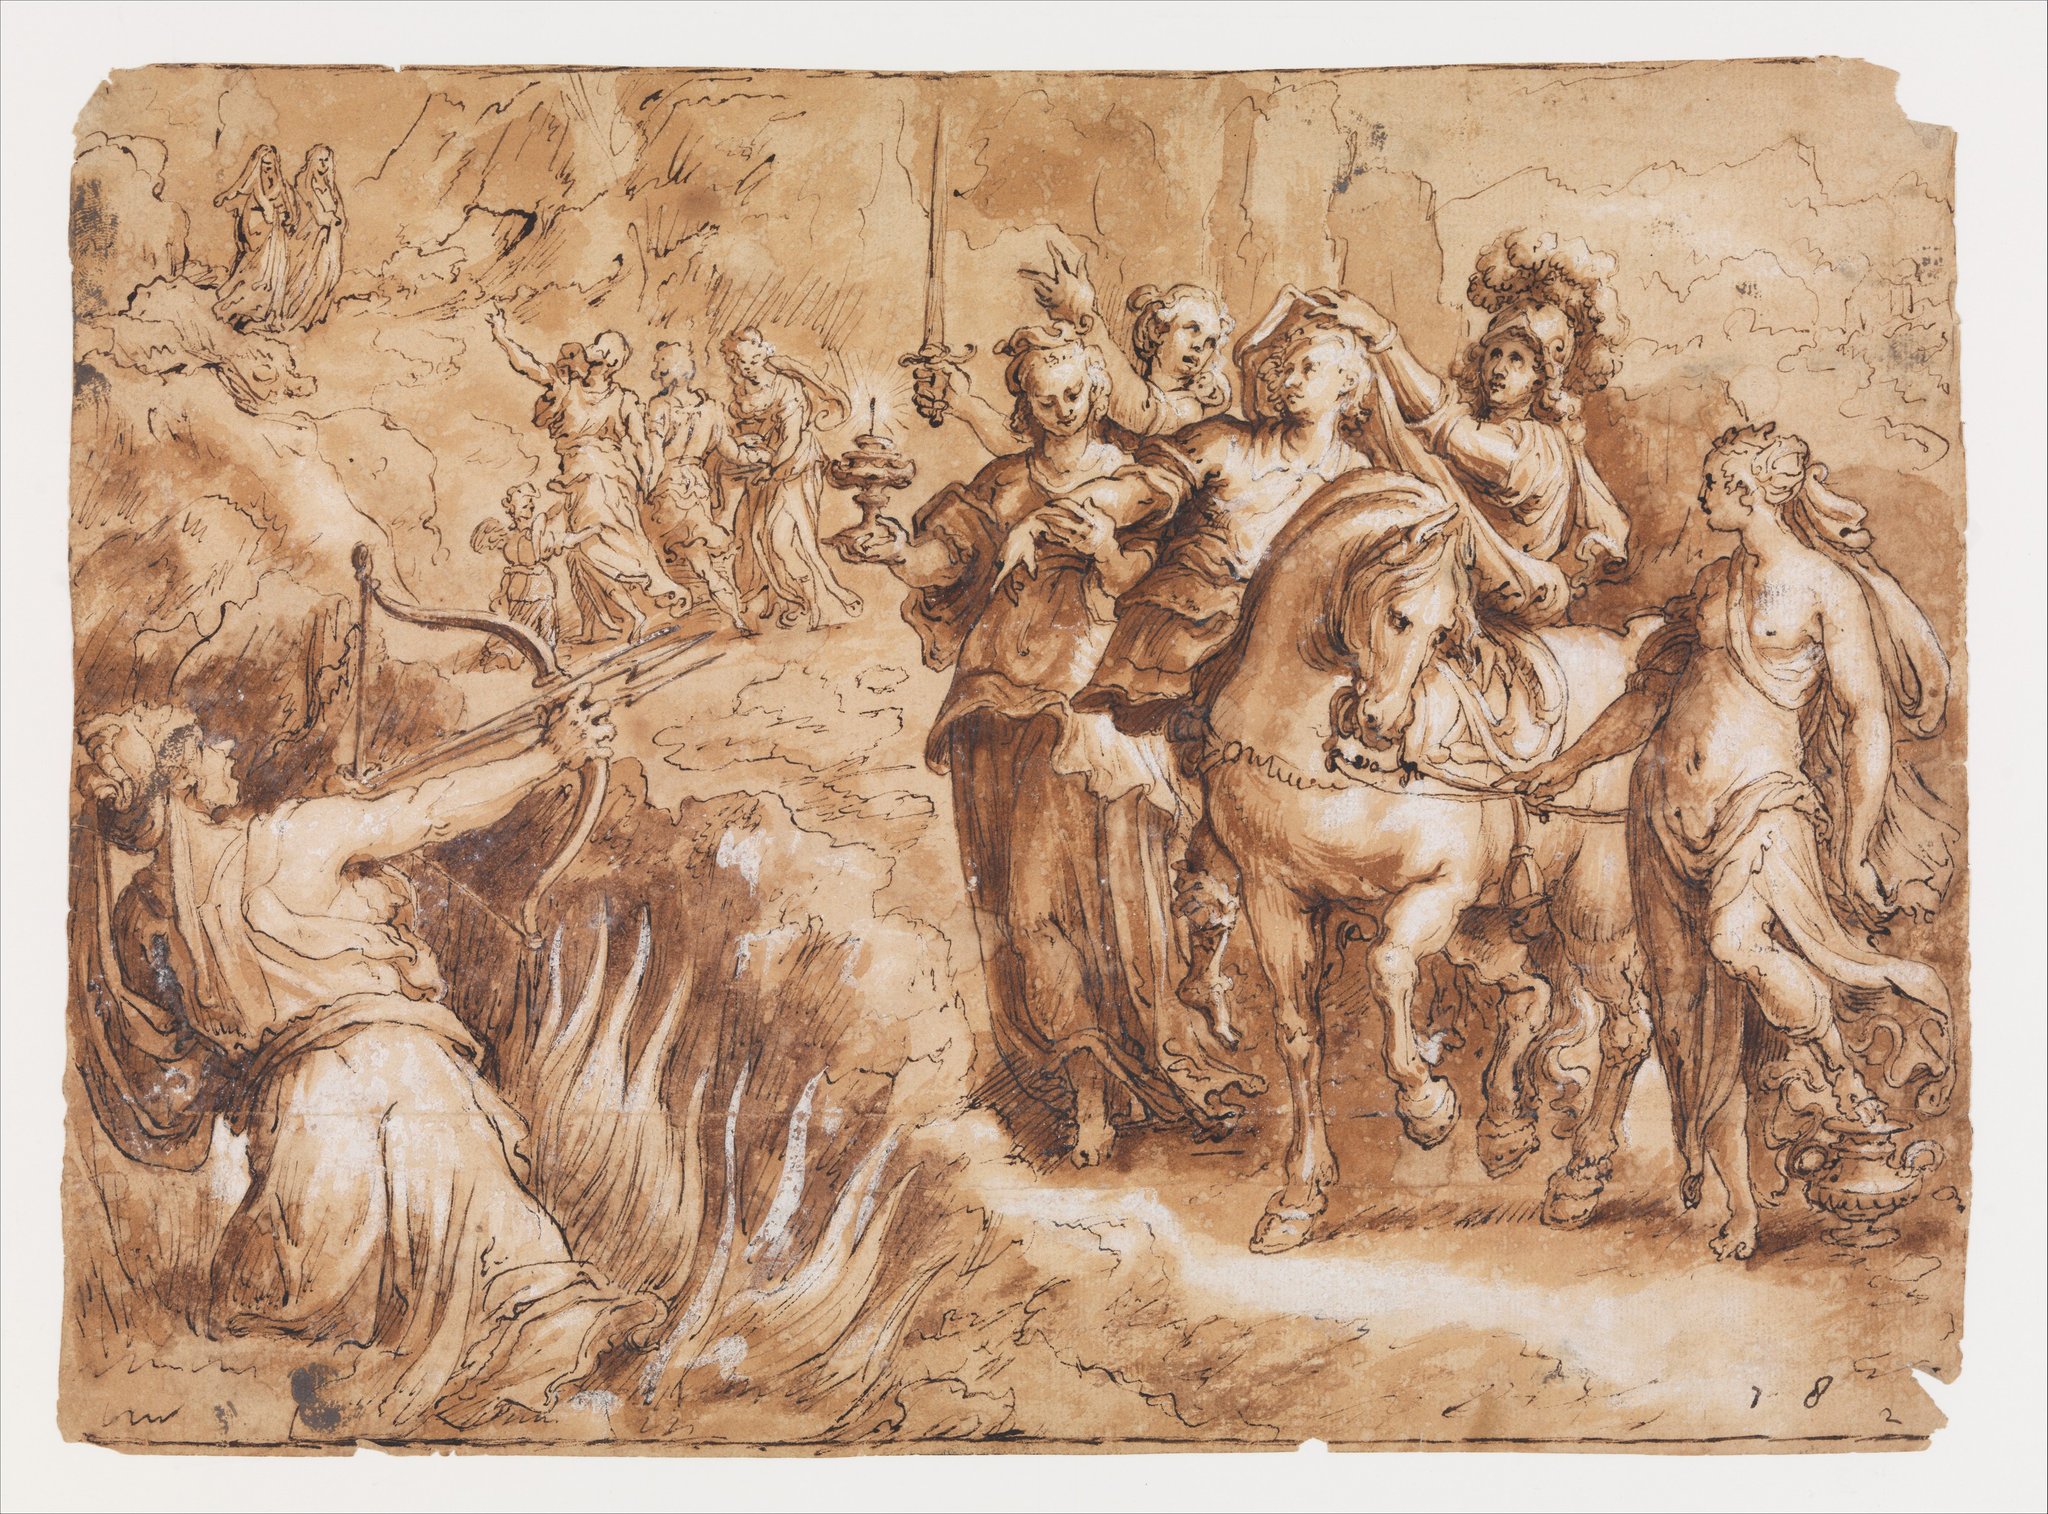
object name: drawing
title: Allegory of the Course of Human Life (Choosing Virtue)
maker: jan van der straet, called stradanus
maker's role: artist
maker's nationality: netherlandish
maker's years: 1523-1605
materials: ink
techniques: brush, heightening, pen, wash